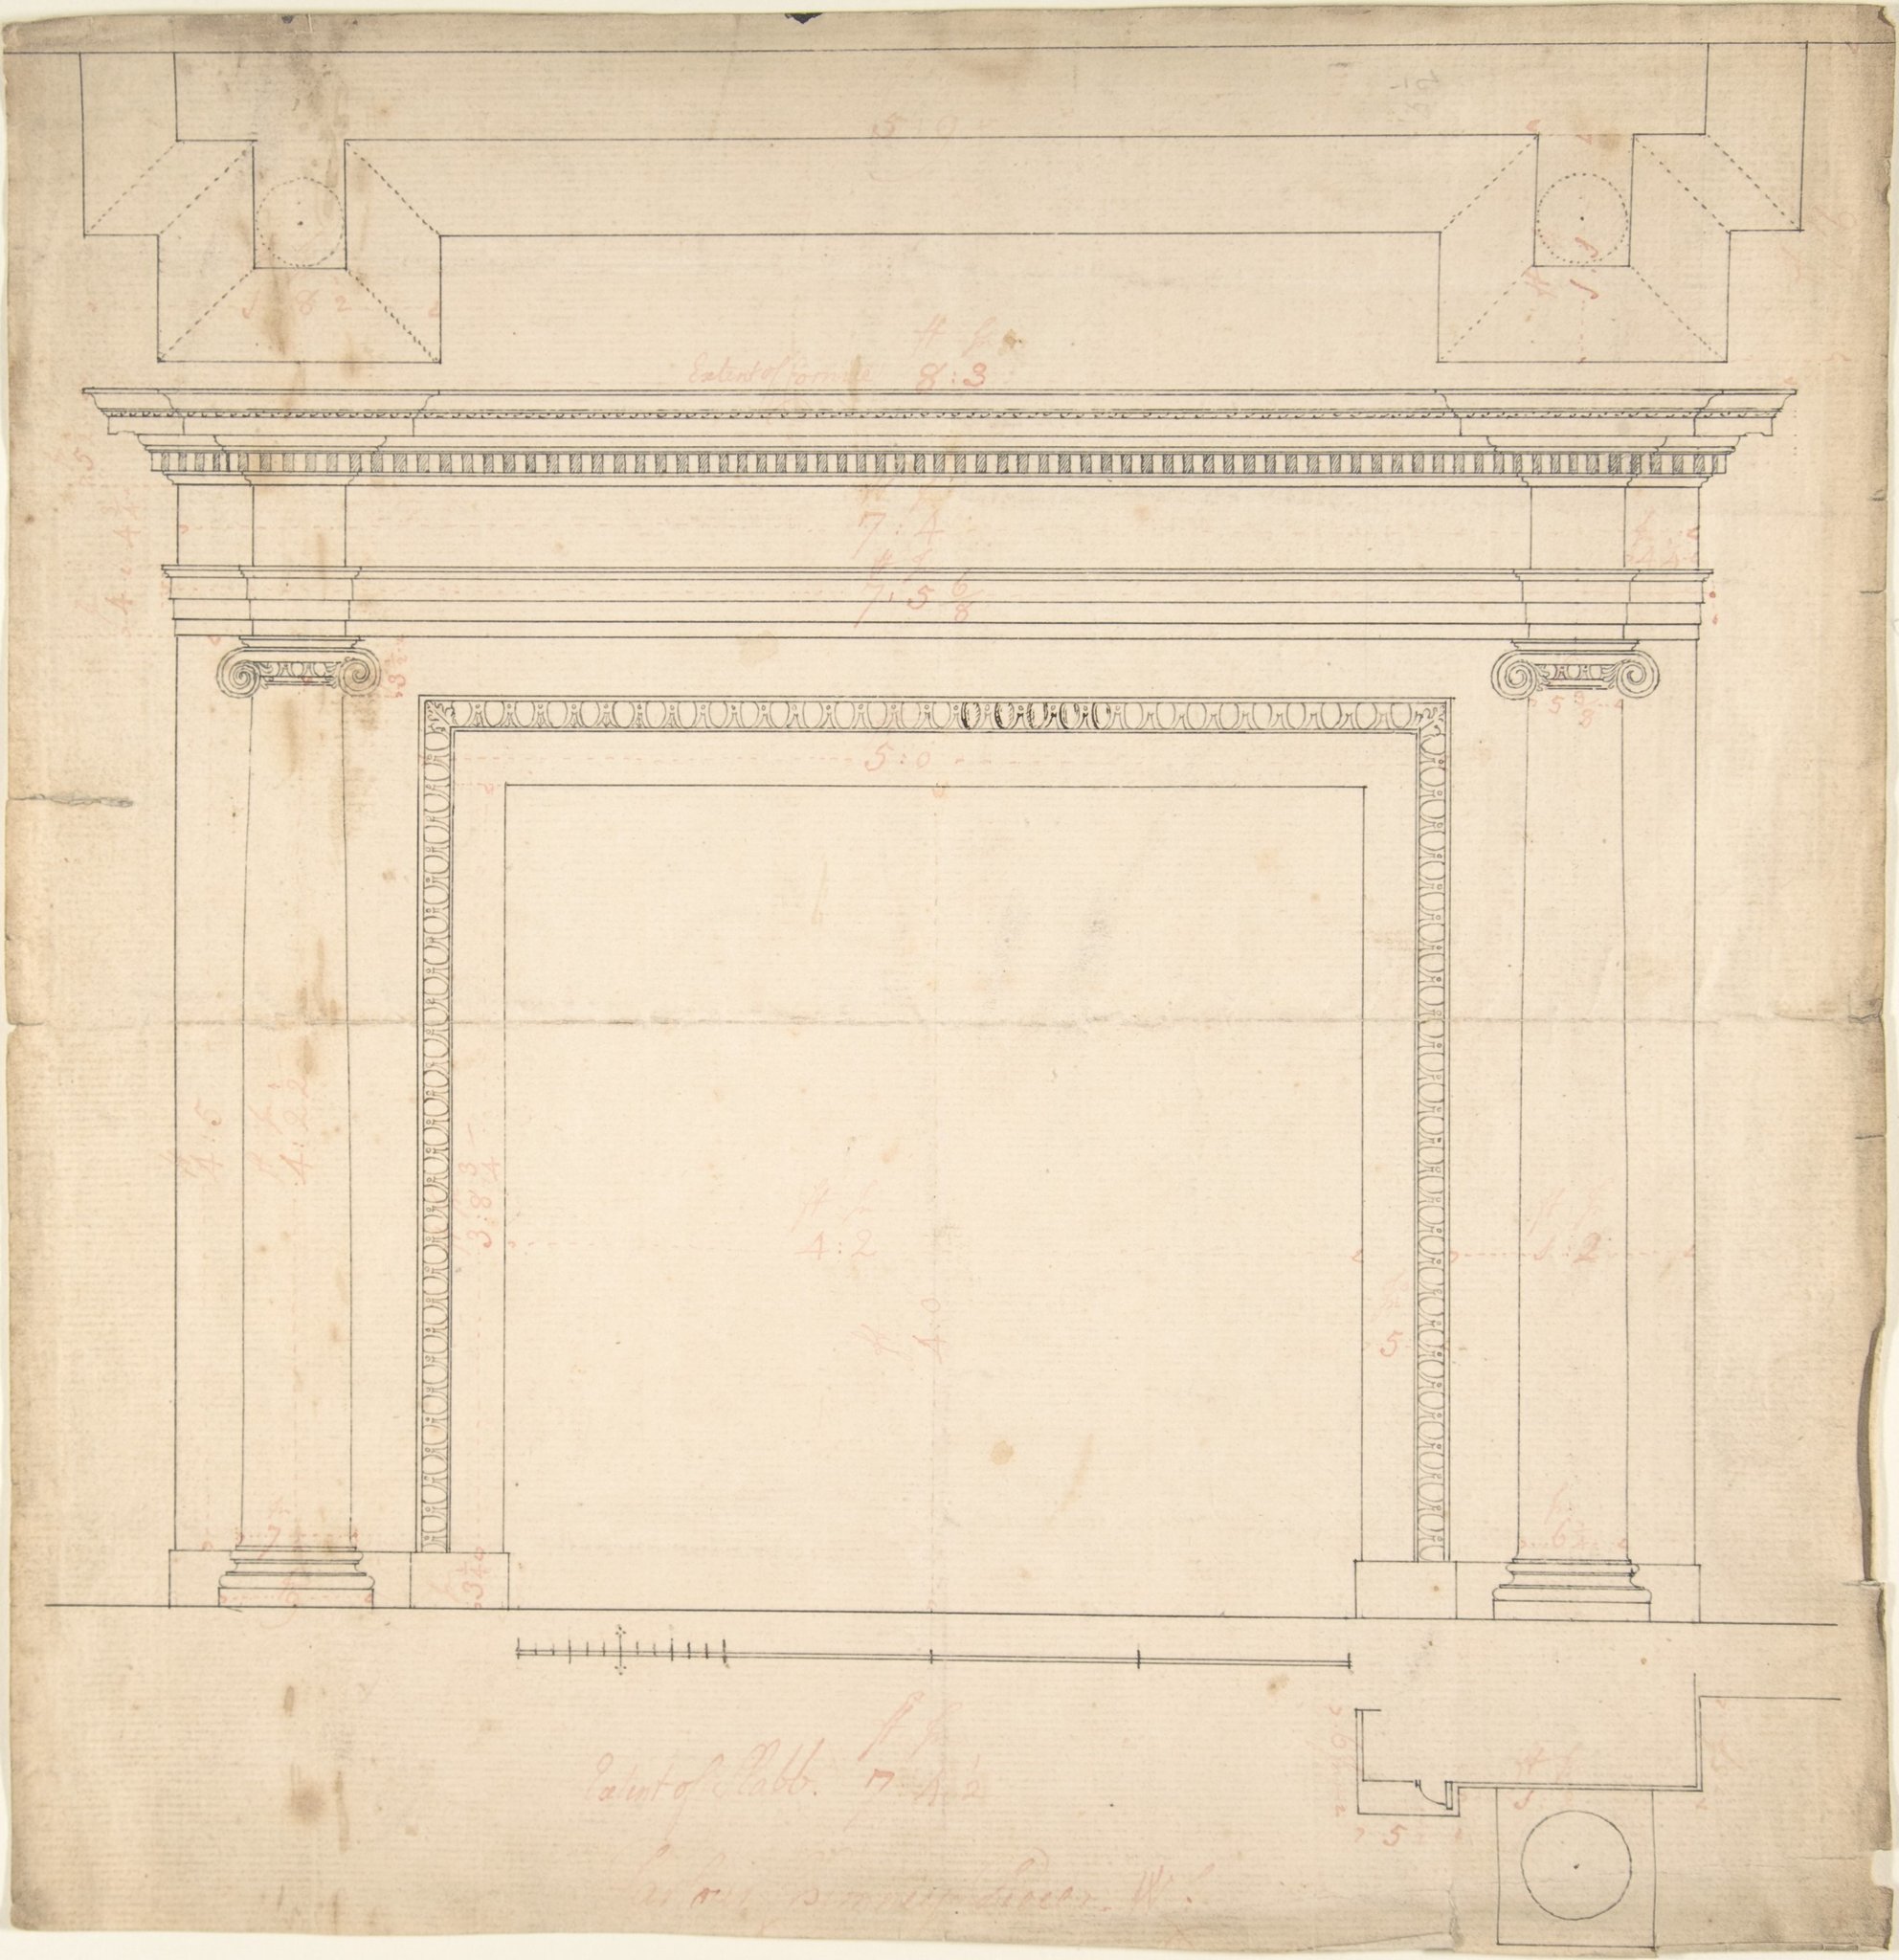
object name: drawing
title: Design for a Chimneypiece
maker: sir william chambers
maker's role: artist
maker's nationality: british, born sweden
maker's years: 1723-1796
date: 1740-1800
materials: ink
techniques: pen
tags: fireplaces